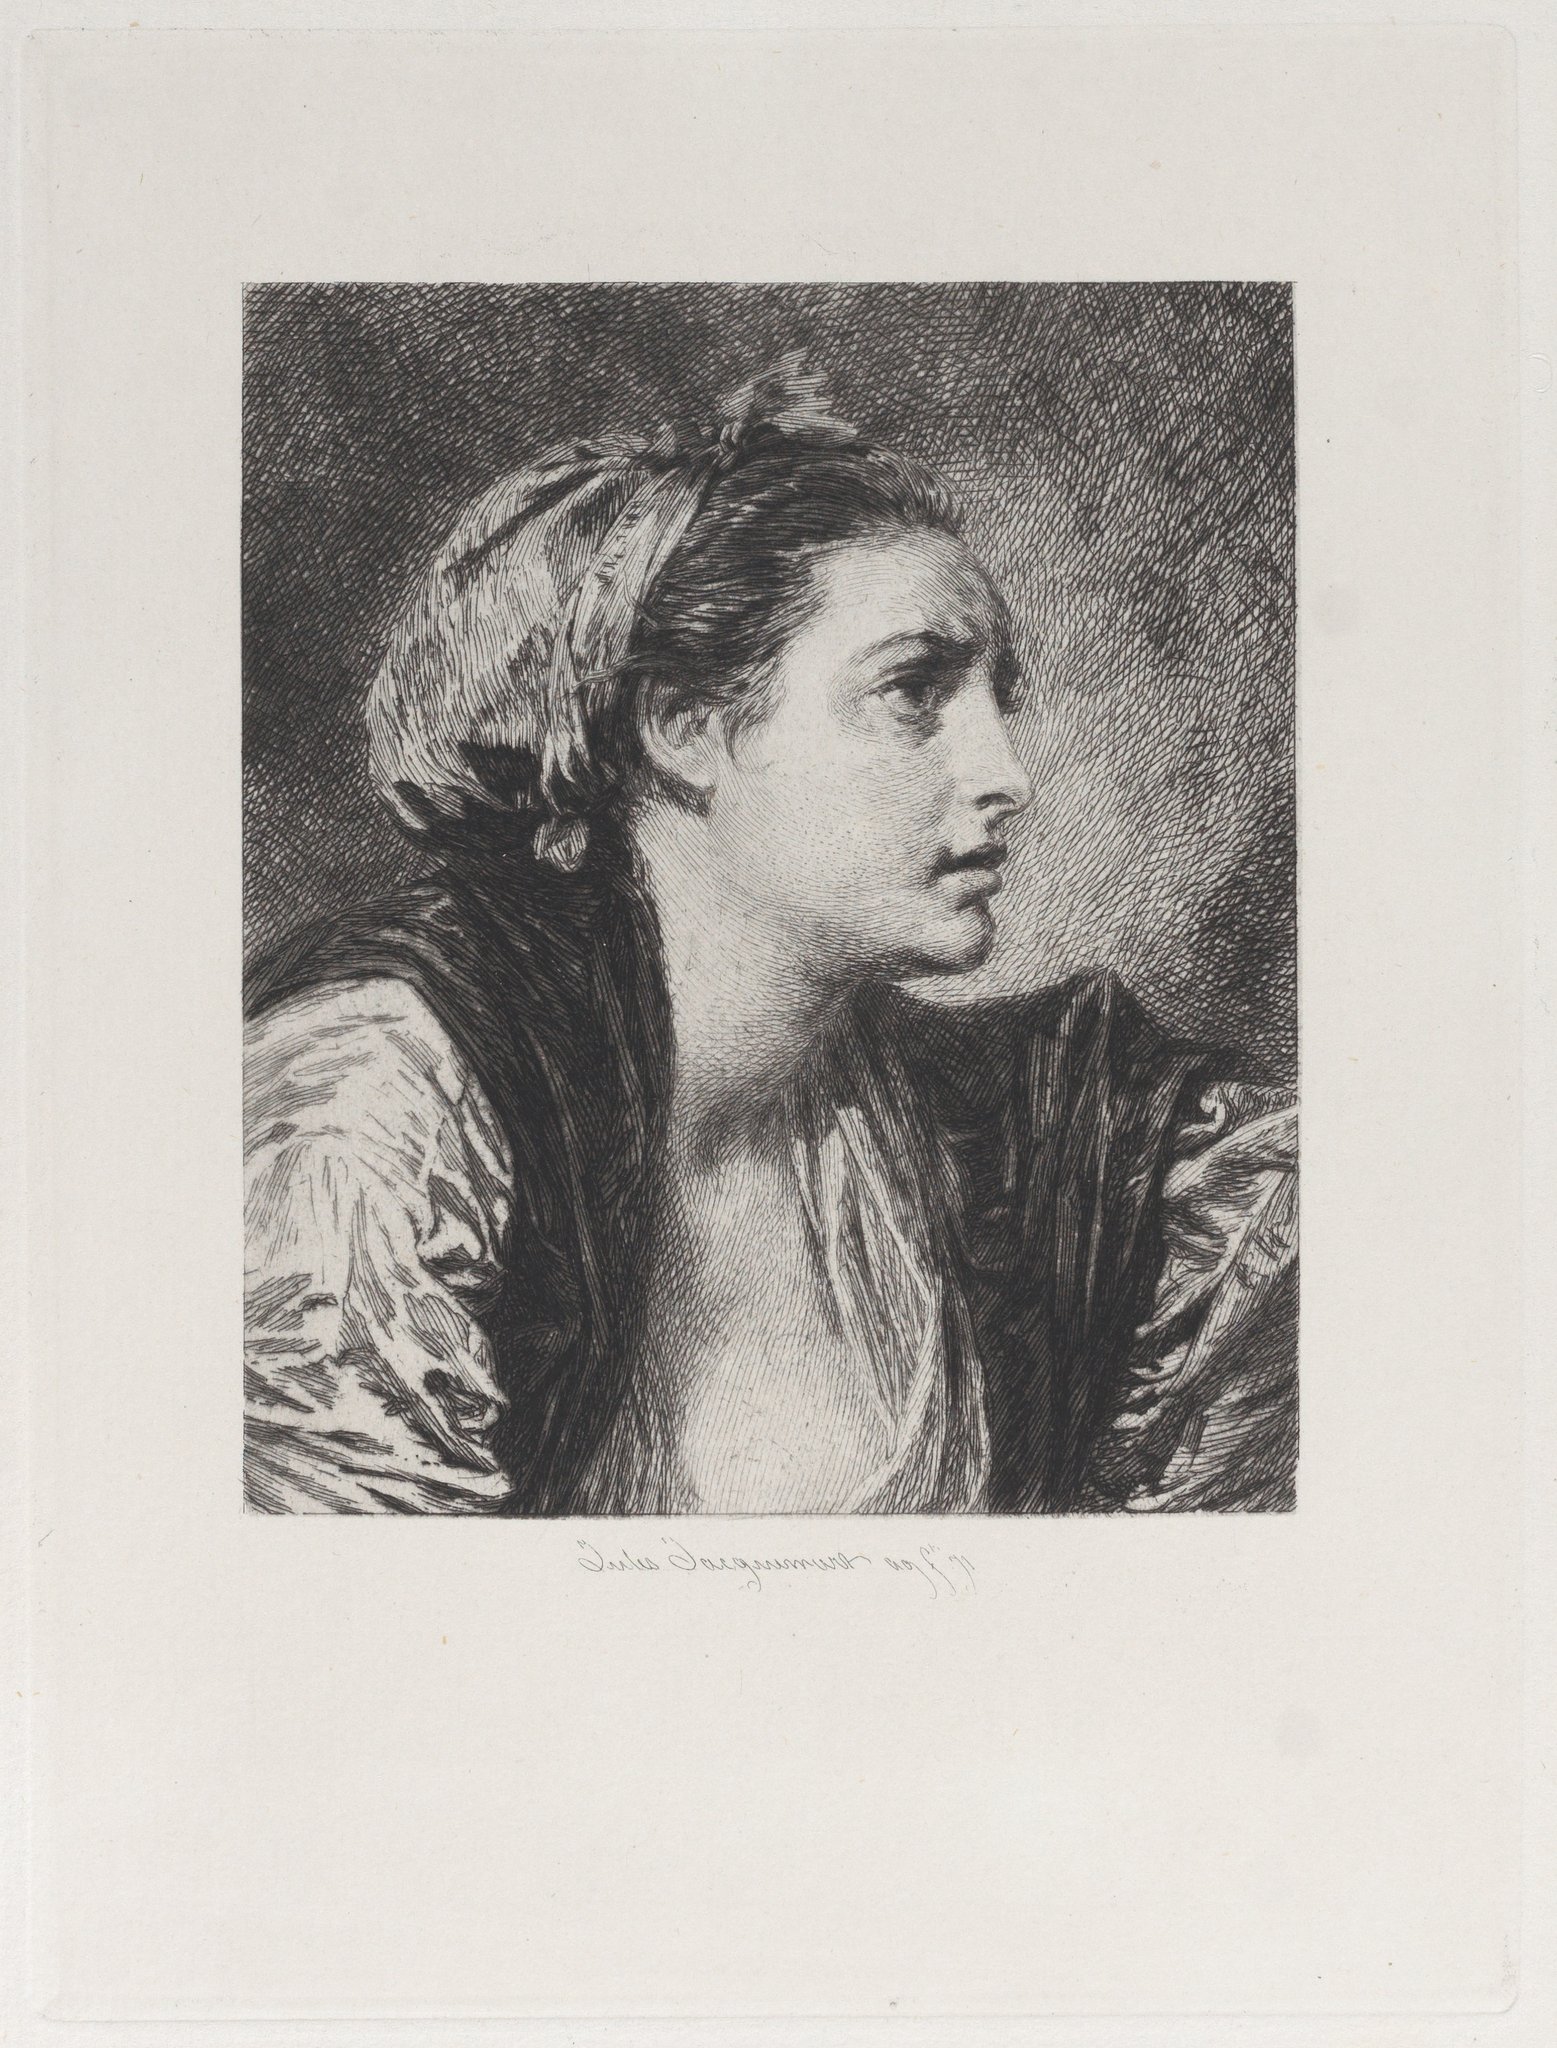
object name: print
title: Head of a Woman, after Greuze, from "Etchings of Pictures in the Metropolitan Museum New York"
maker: jules-ferdinand jacquemart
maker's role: artist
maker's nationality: french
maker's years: 1837-1880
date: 1871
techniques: etching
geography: london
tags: women